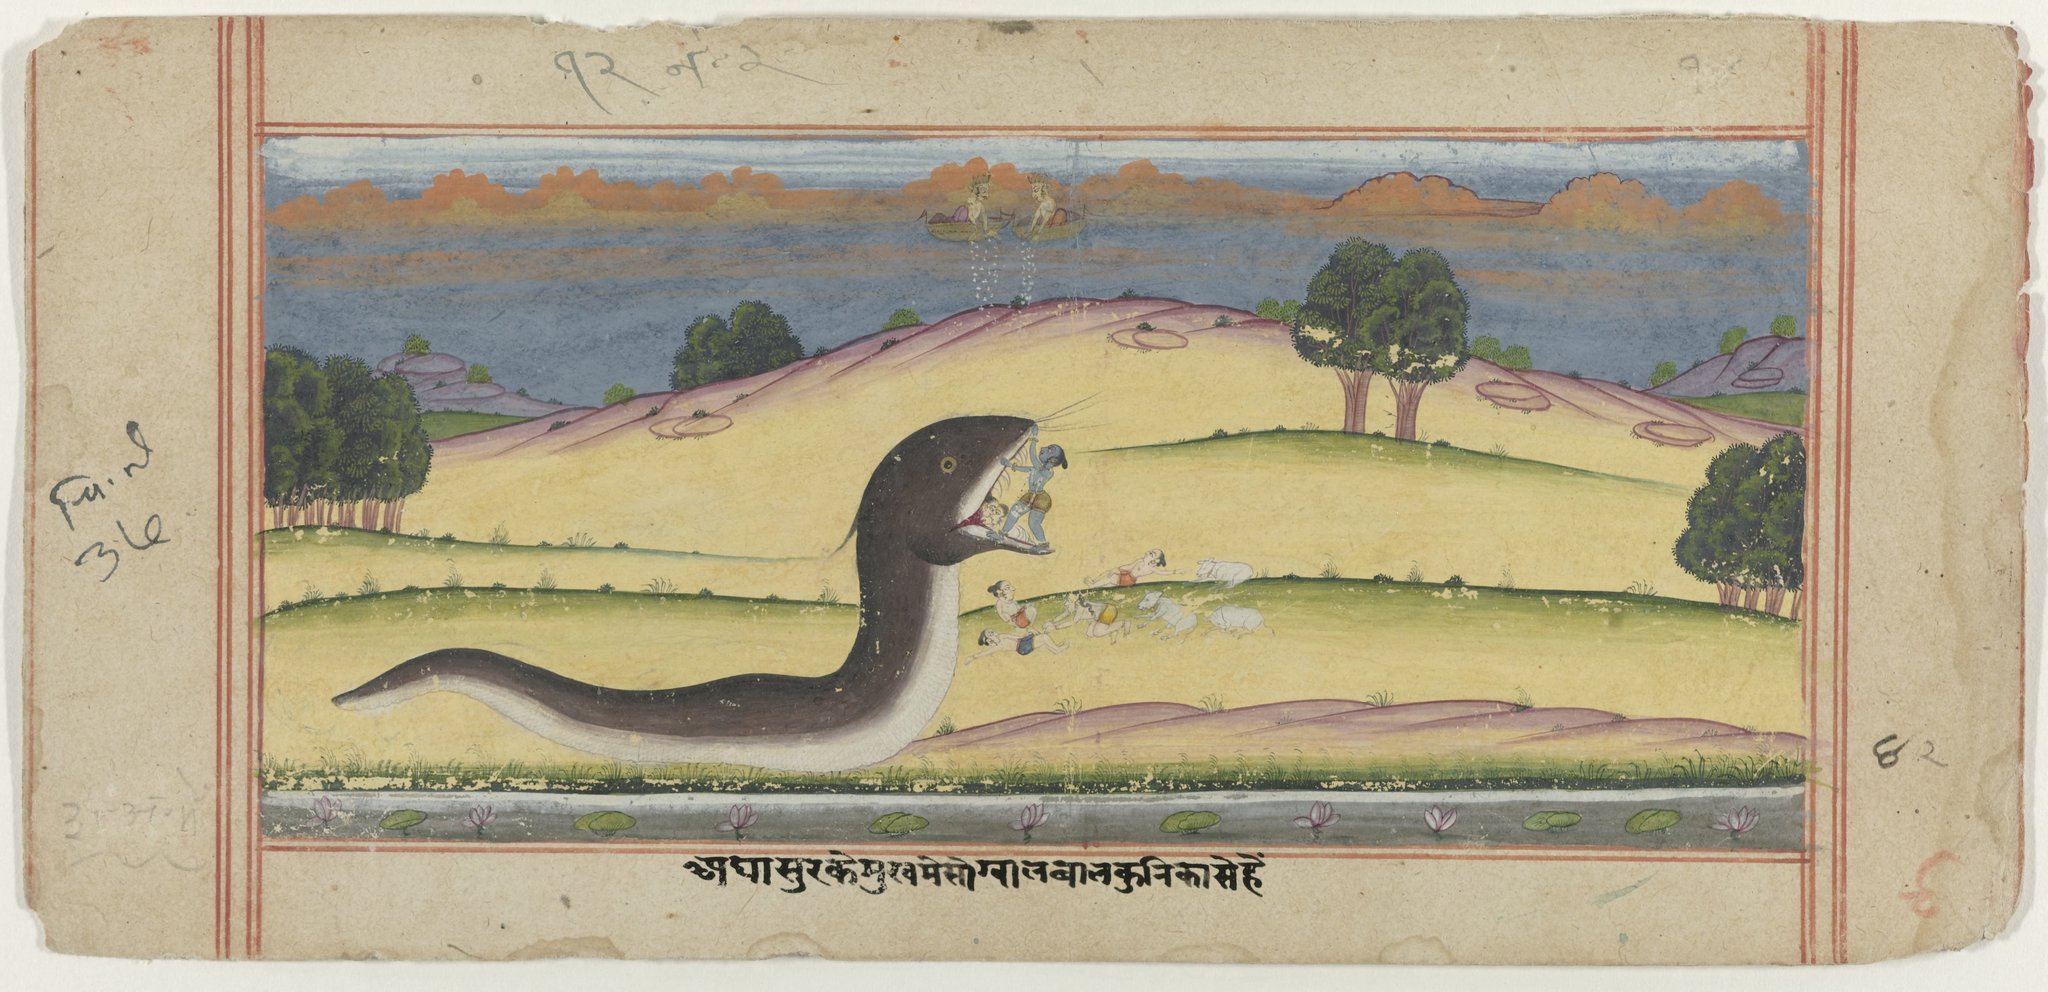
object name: indian miniature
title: Krishna doodt slang-demon Aghasura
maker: Anonymous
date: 1700-1799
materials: paper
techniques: brush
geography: bikaner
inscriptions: inscription